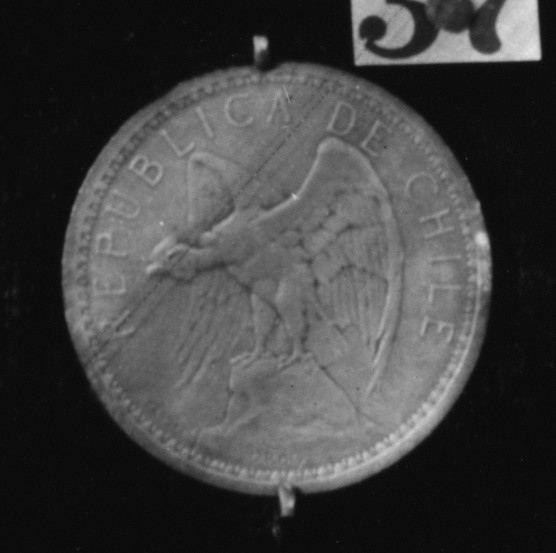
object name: peso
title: Chilean peso piece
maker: louis-oscar roty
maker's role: artist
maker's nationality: french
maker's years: 1846-1911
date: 1894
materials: silver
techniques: struck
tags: birds,coins